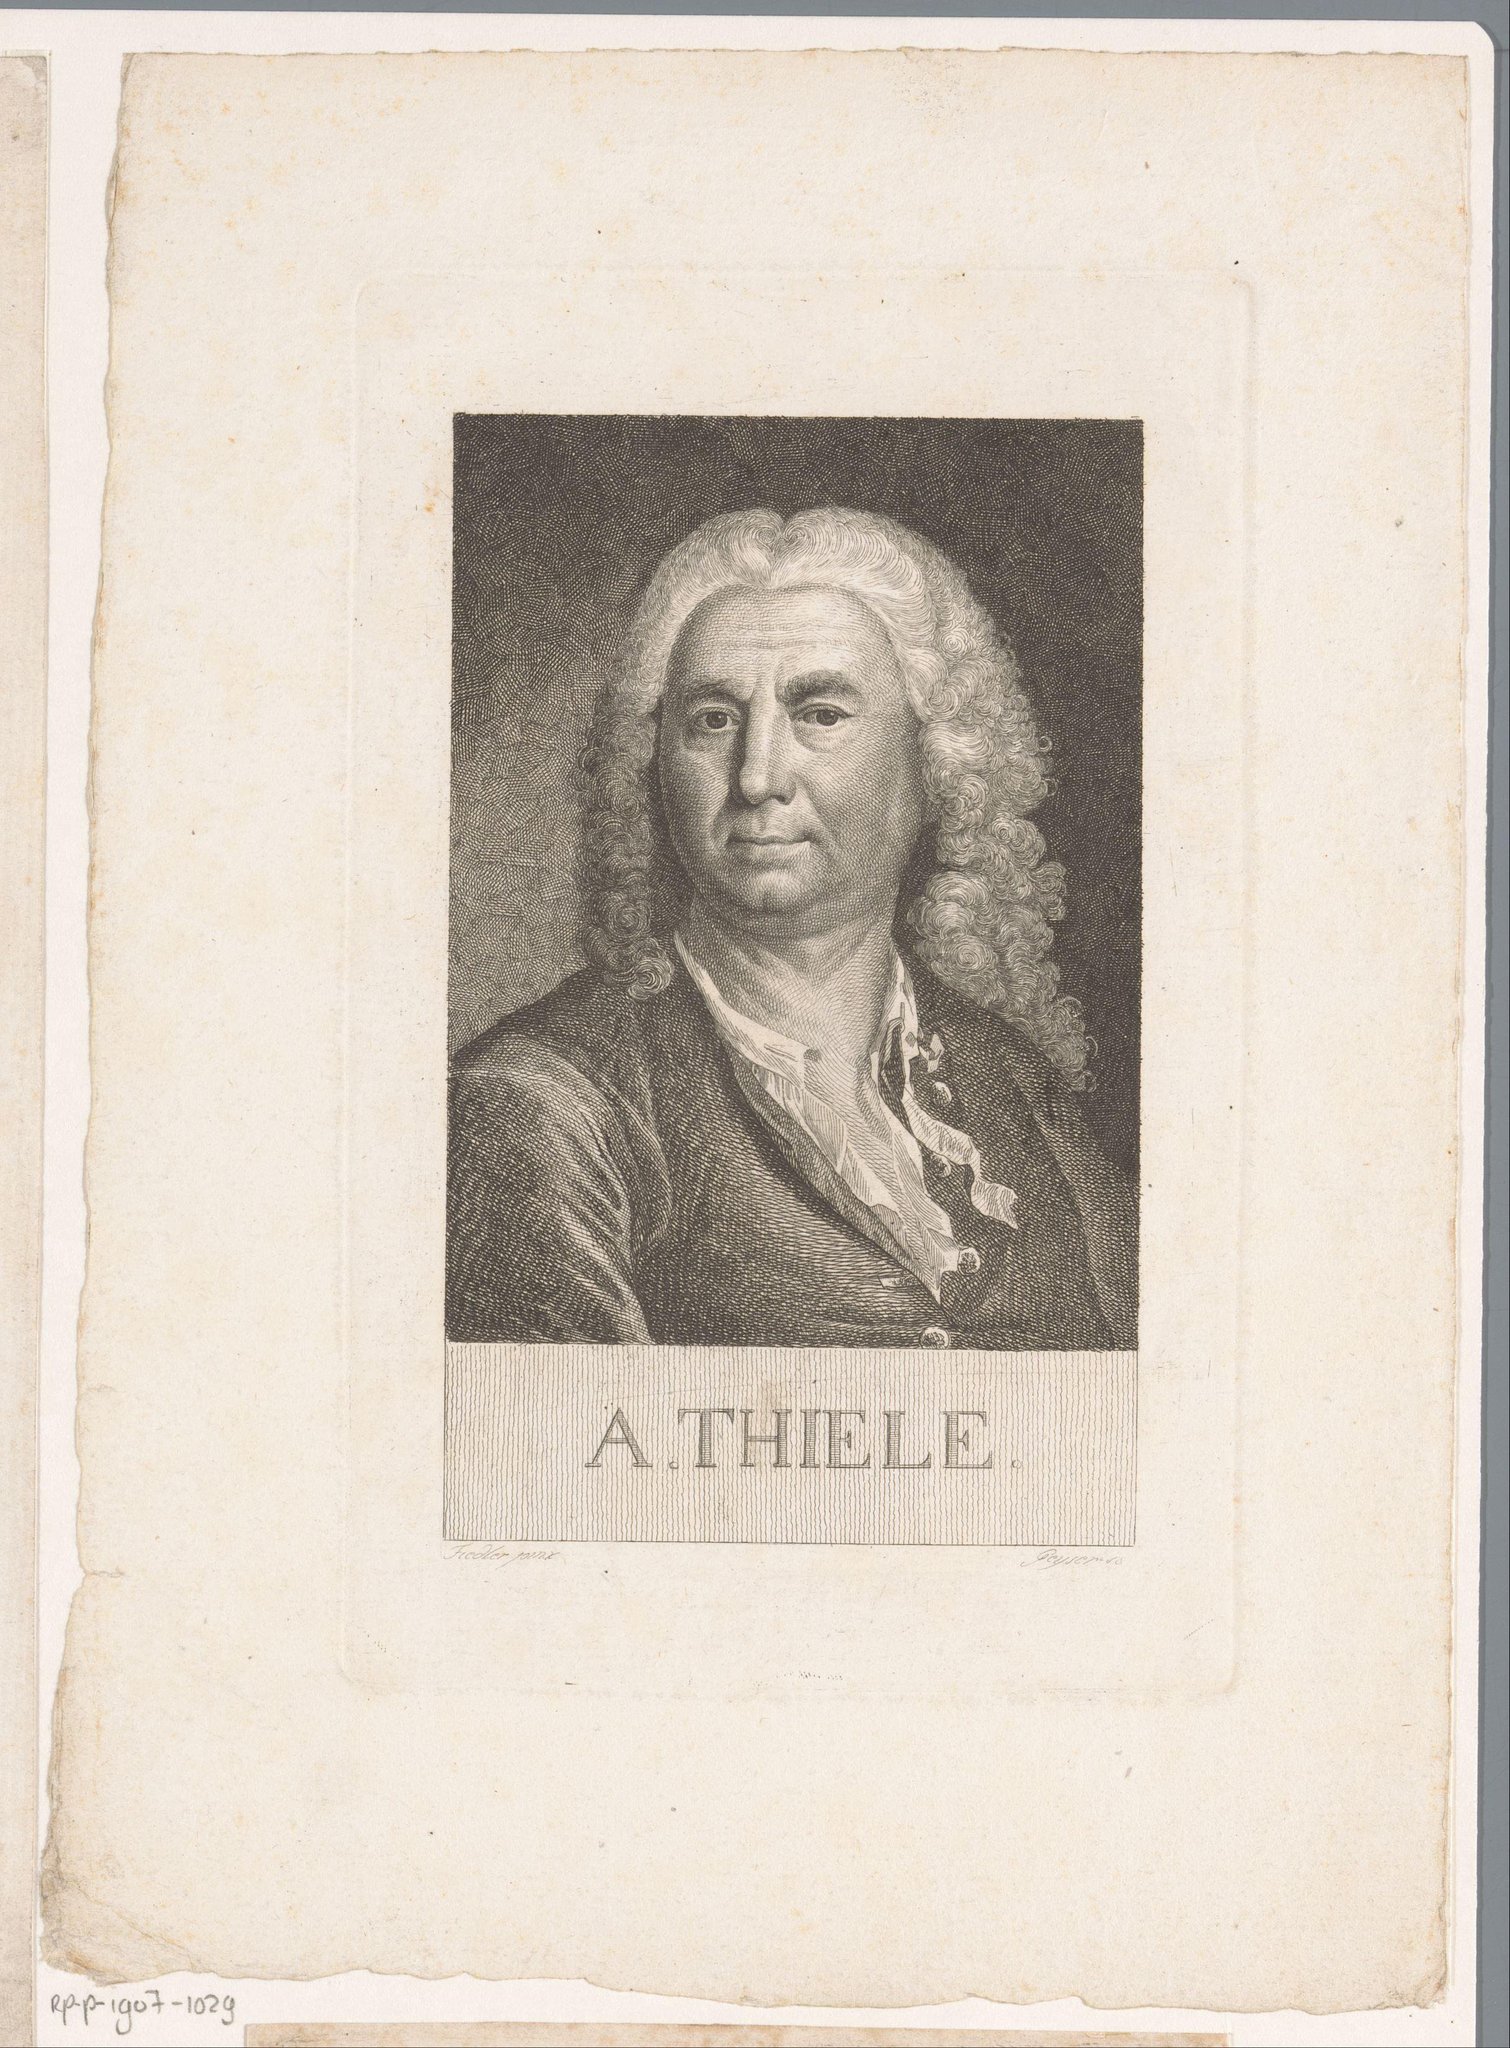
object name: print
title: Portret van Alexander Thiele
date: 1752-1803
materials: paper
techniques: engraving, etching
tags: alexander thiele, historical persons, portrait, self-portrait of painter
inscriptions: collector's mark: Lugt 2228